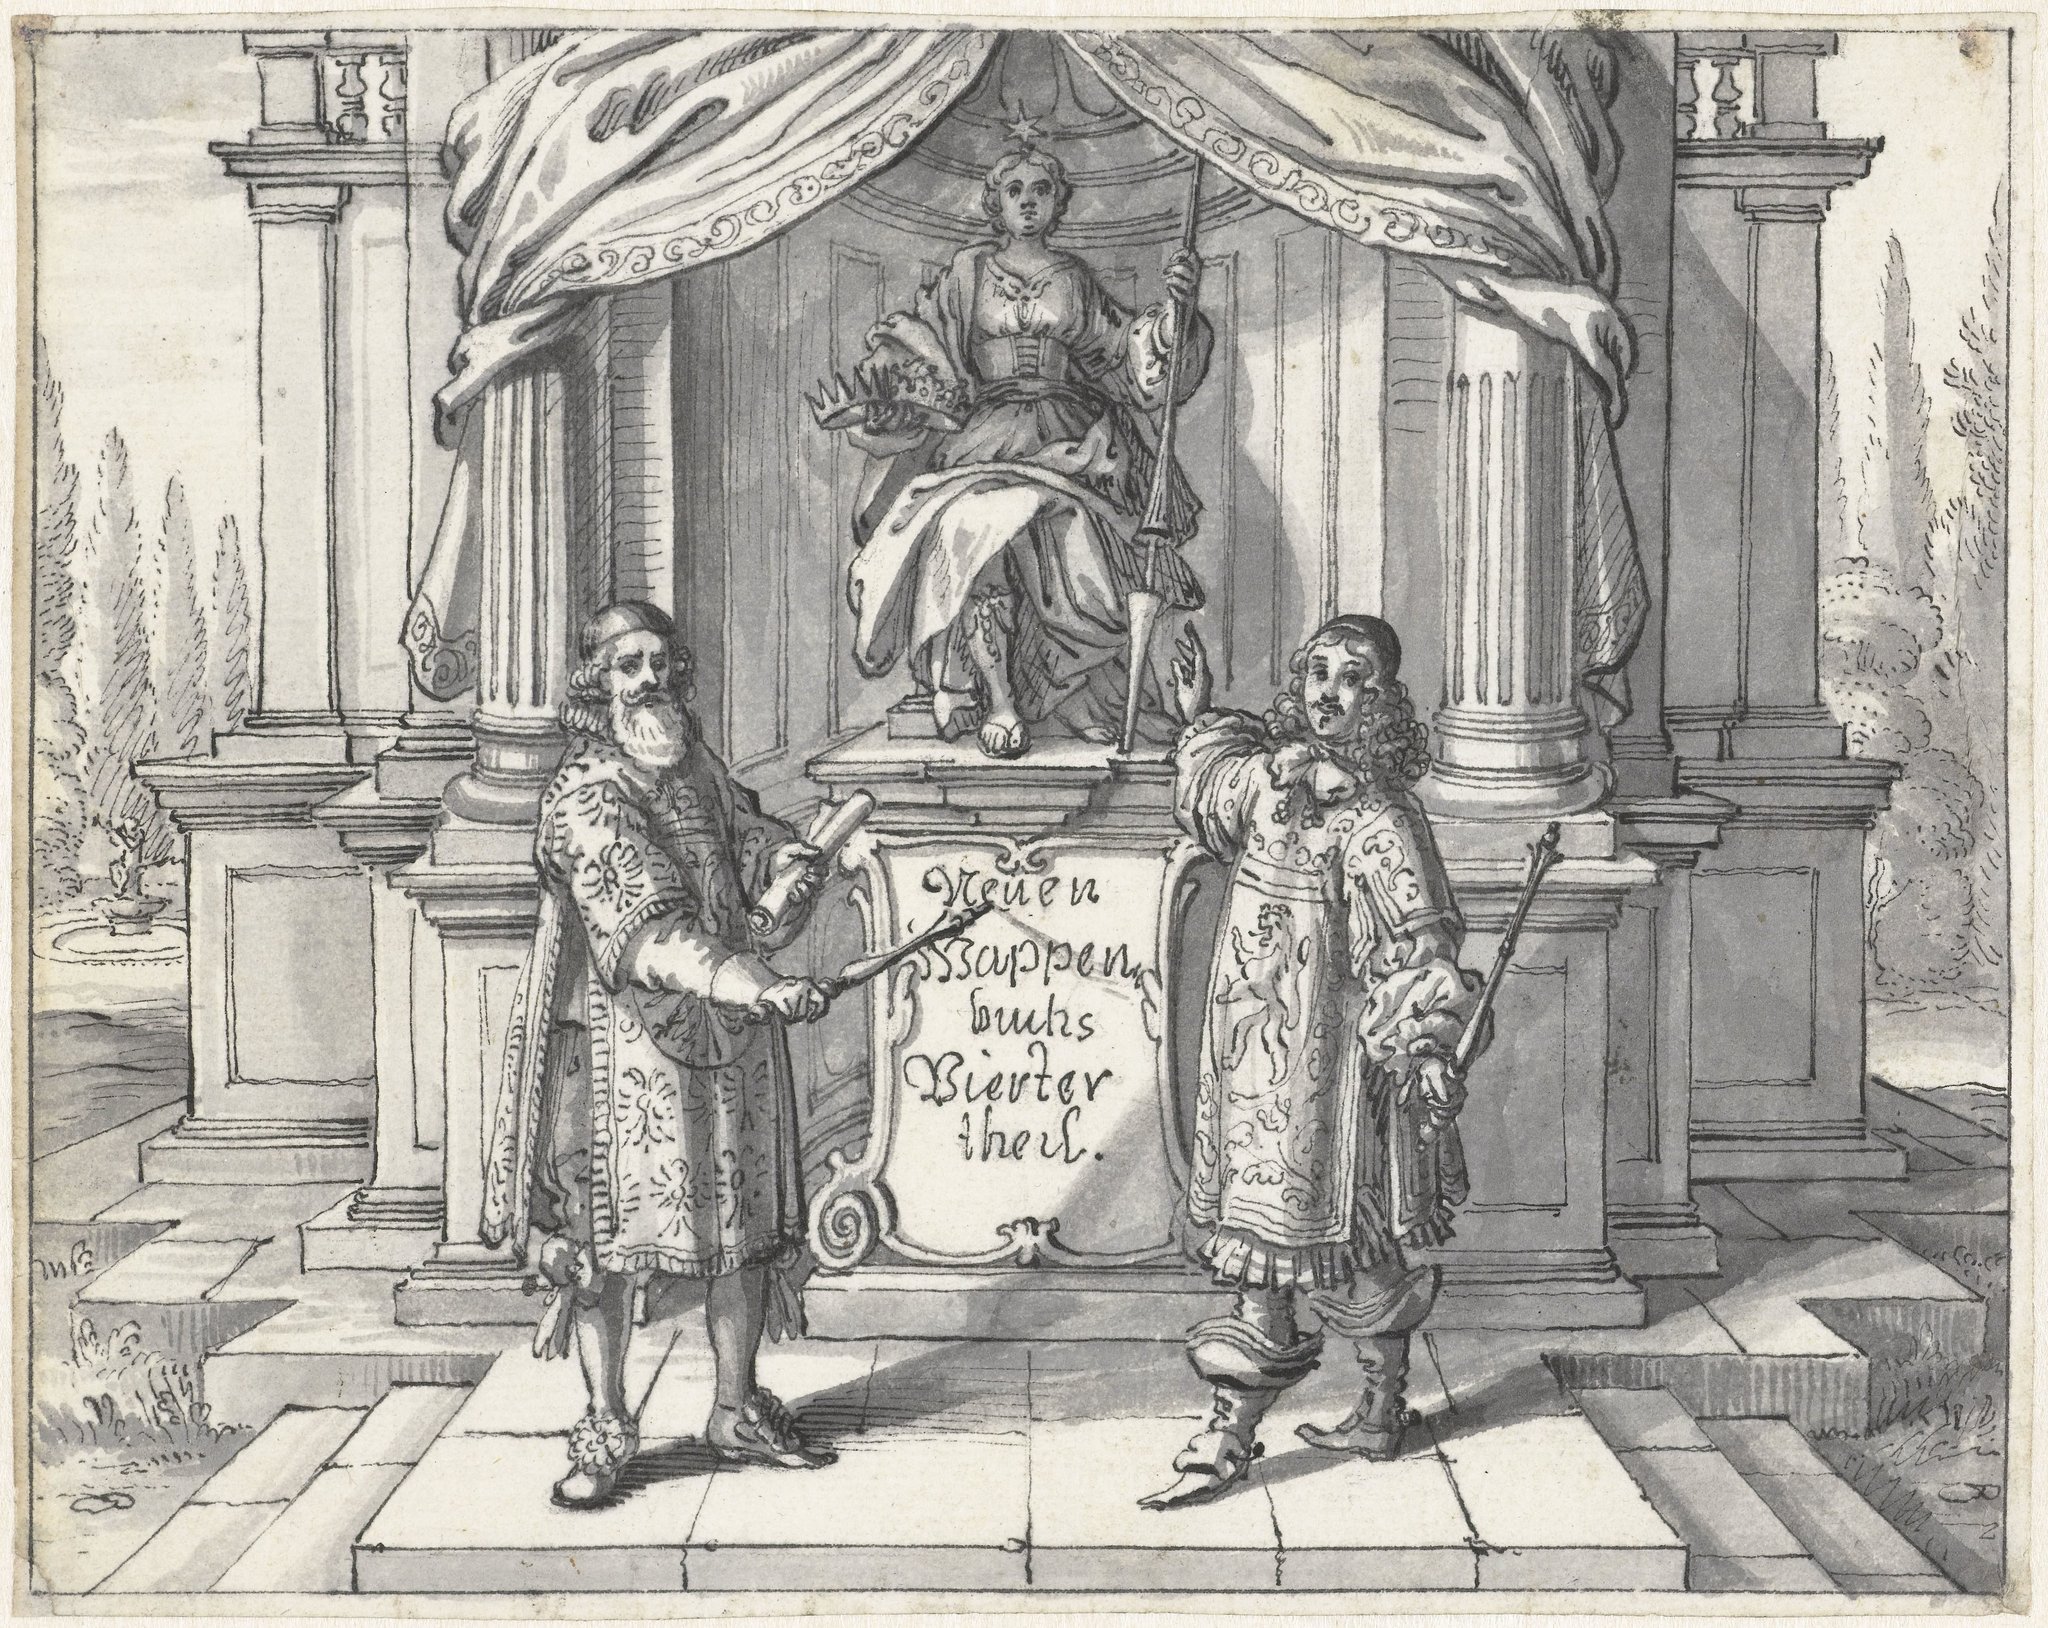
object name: design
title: Ontwerp voor het frontispiece van Dess neuen Teutschen Wappenbuchs Vierter Teil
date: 1650-1657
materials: graphite, ink, paper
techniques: brush, pen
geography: nuremberg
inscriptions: inscription: ‘Neuen/Wappen/buchs/Vierter/theil.’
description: Ontwerp voor het frontispiece van: (J. Sibmacher), Dess Neuen Teutschen Wappenbuchs Vierter Theil, Nürnberg, Paulus Fürsten, 1657